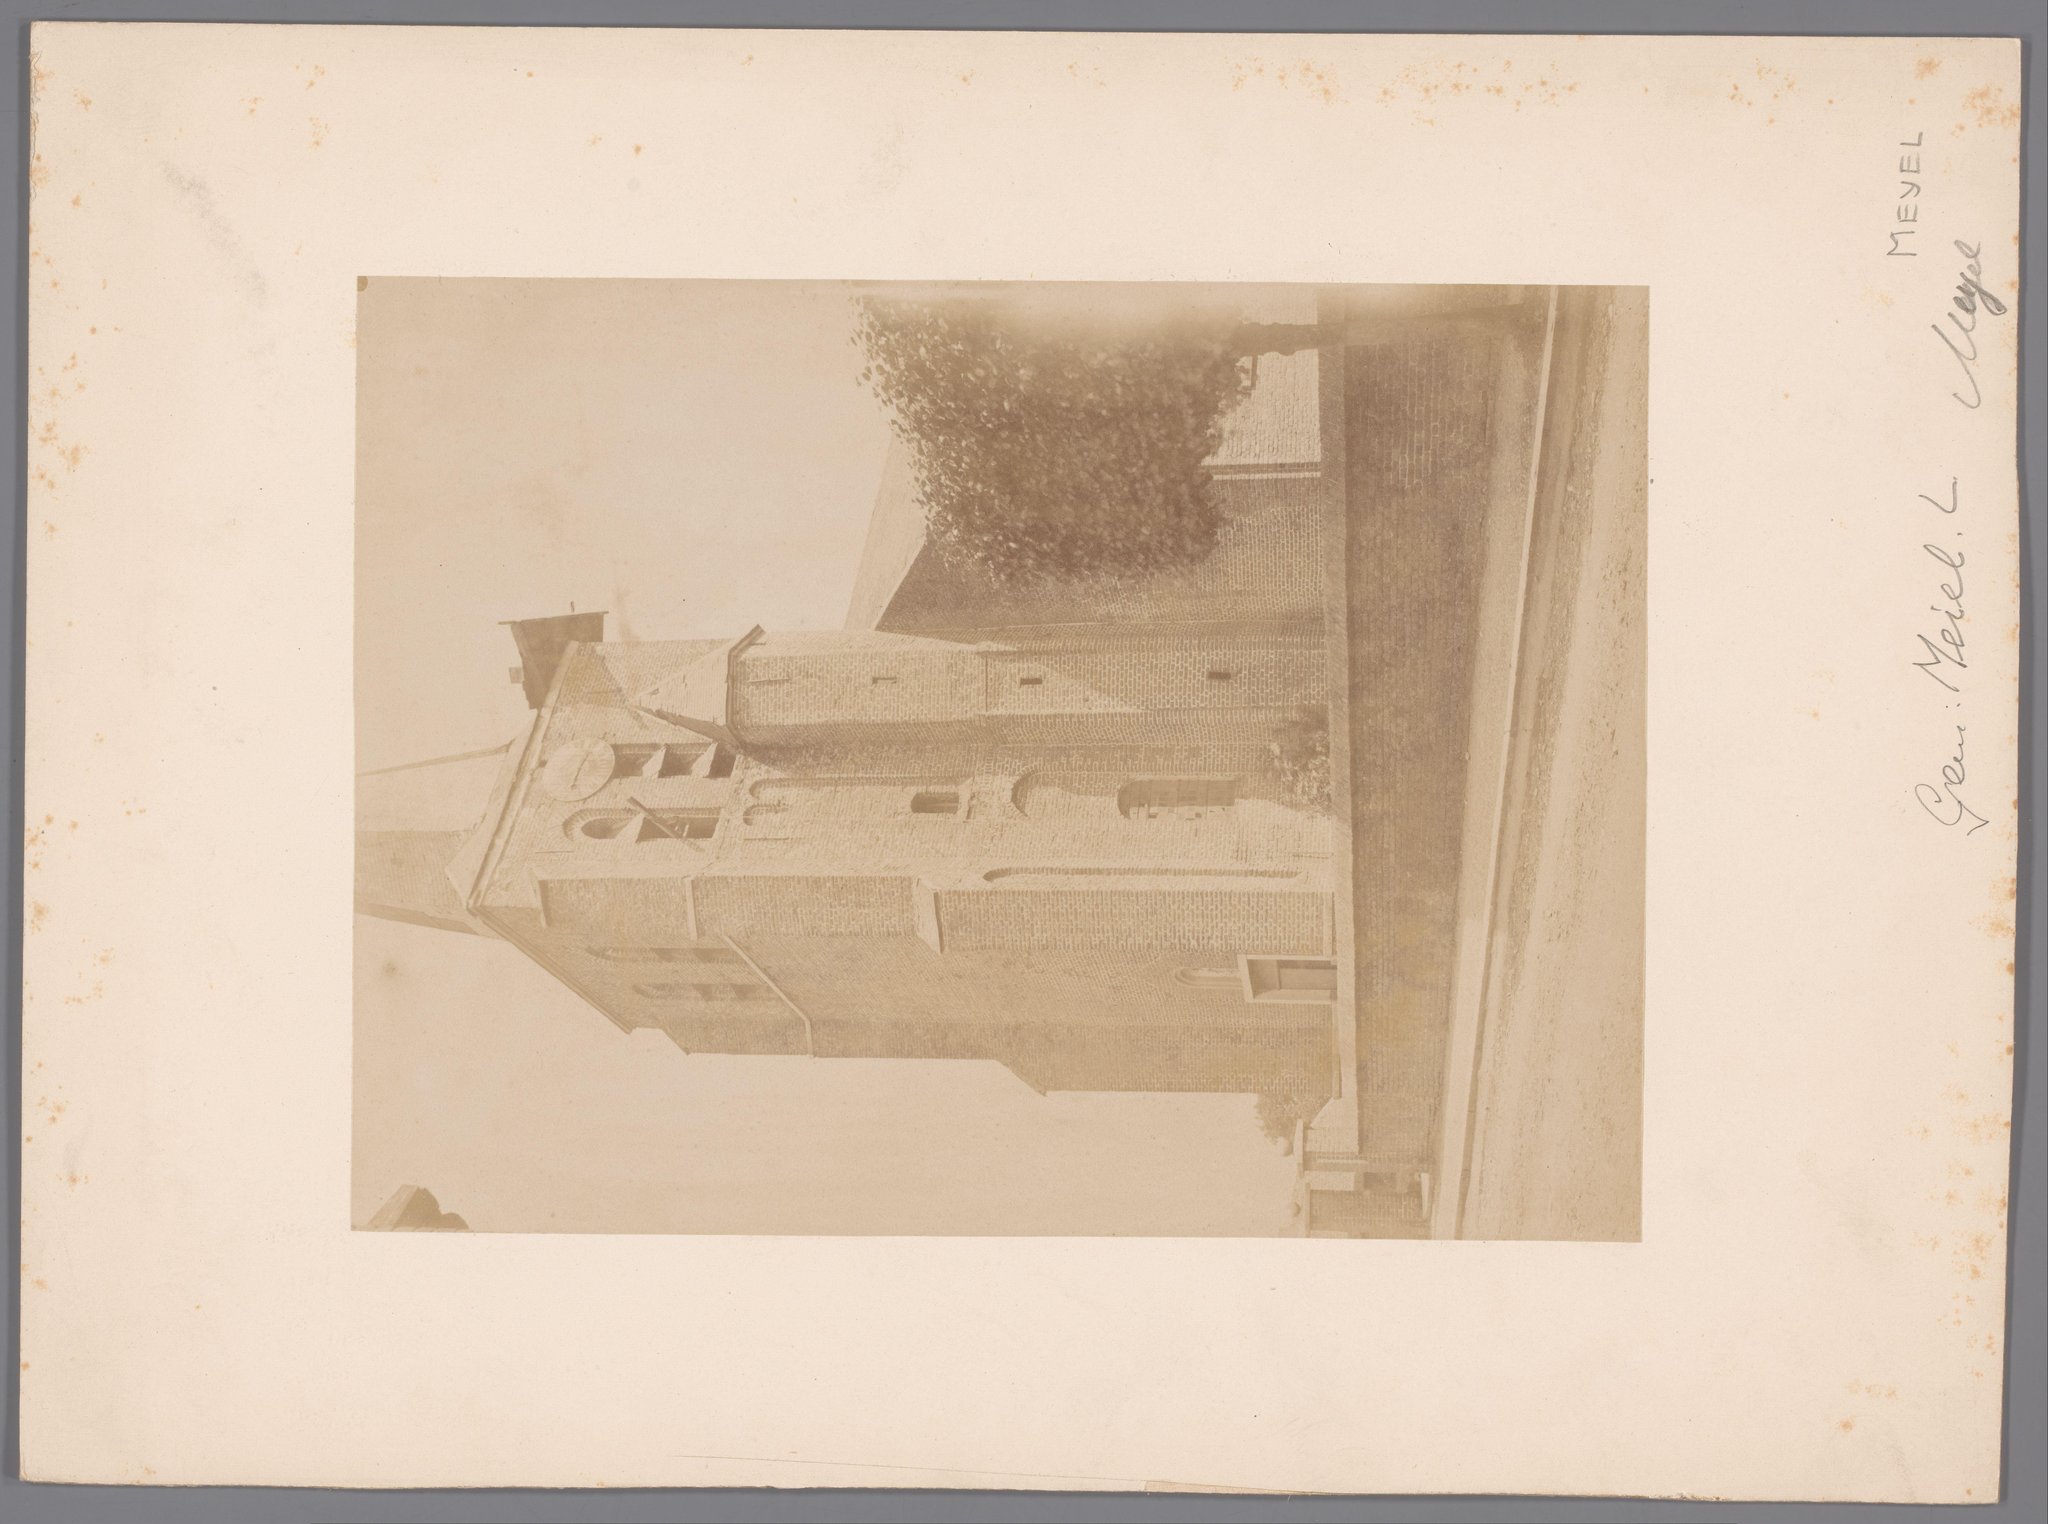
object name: photograph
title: Toren van de Rooms-Katholieke Kerk te Meijel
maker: anoniem (monumentenzorg)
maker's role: fotograaf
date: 1890-1920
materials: cardboard, photographic support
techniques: albumen print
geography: meijel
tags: parts of church exterior and annexes: tower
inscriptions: annotation: ‘Gem. Meiel, L/ Meyel/ Meyel’, annotation: ‘Toren v/d R.K. Kerk te Meel (L.)’